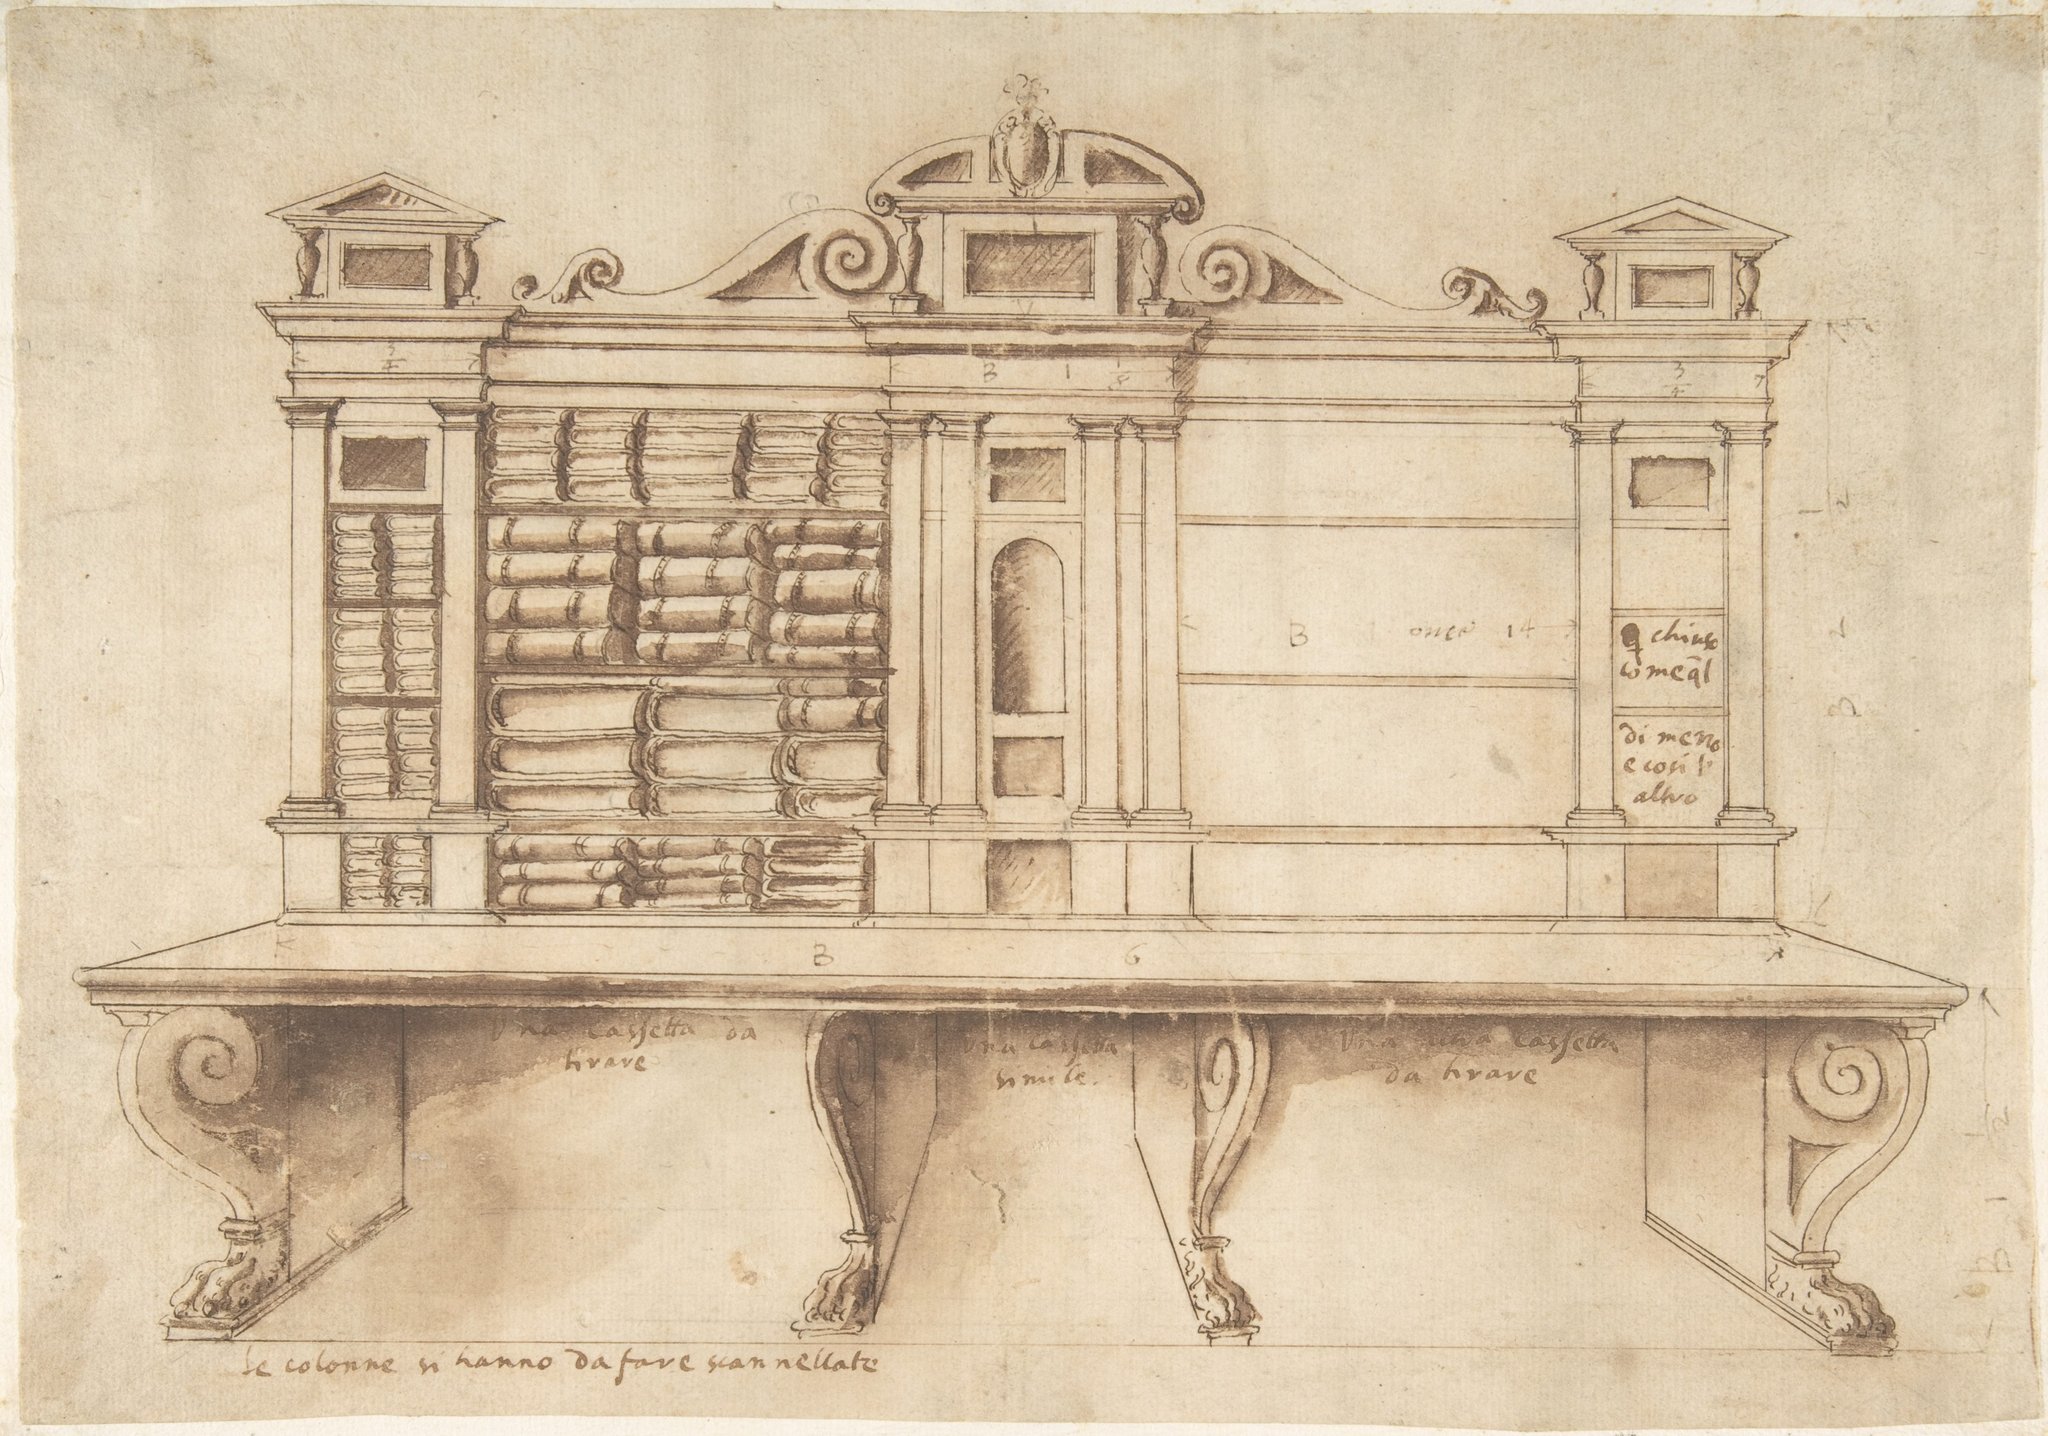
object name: drawing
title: Design for a Bookcase with Writing Desk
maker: anonymous, italian, 16th century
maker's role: artist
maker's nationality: italian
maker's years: 1550-1600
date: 1550-1570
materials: ink, drawing material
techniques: brush, pen, wash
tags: books,desks